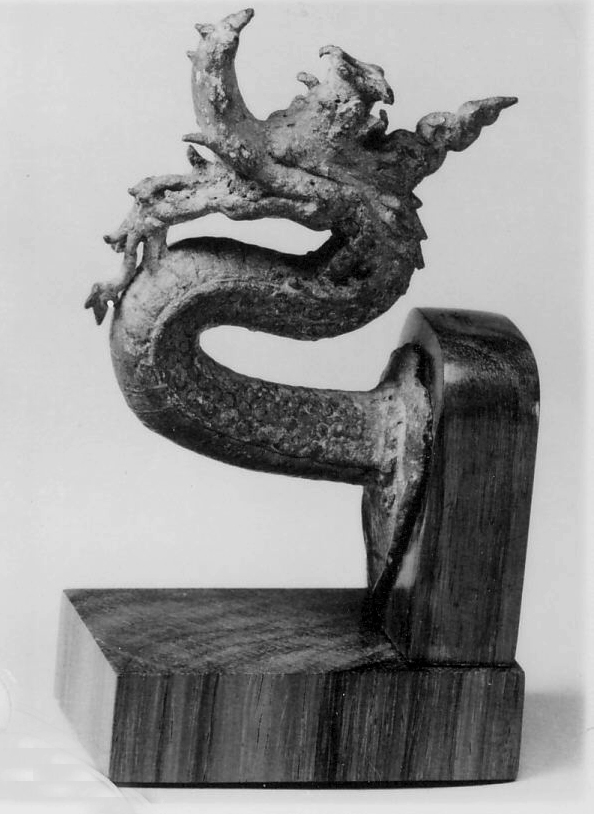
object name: spout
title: Naga Spout from a Holy-Water Bottle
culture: indonesian, javanese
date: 1201-1400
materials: bronze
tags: dragons